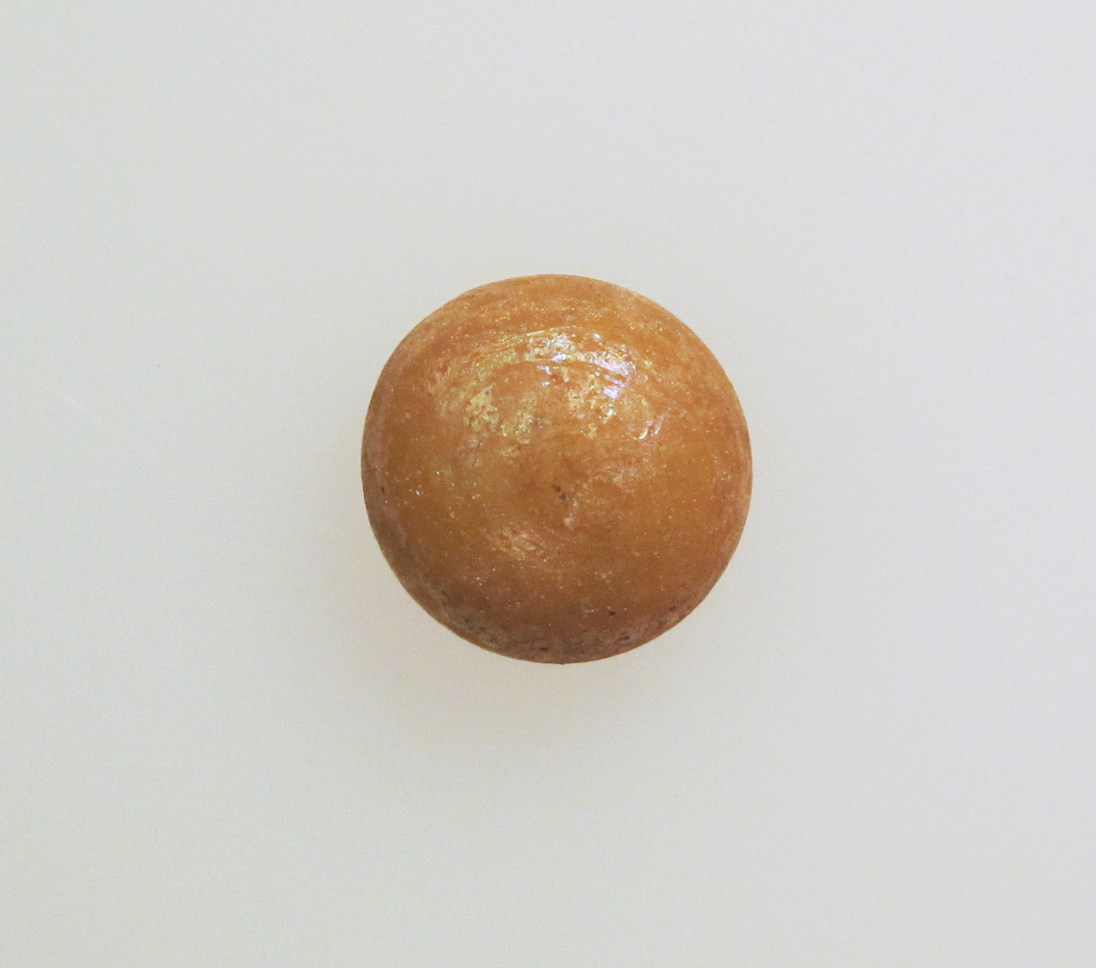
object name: pinhead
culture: roman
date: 100 BCE-500 CE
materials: glass